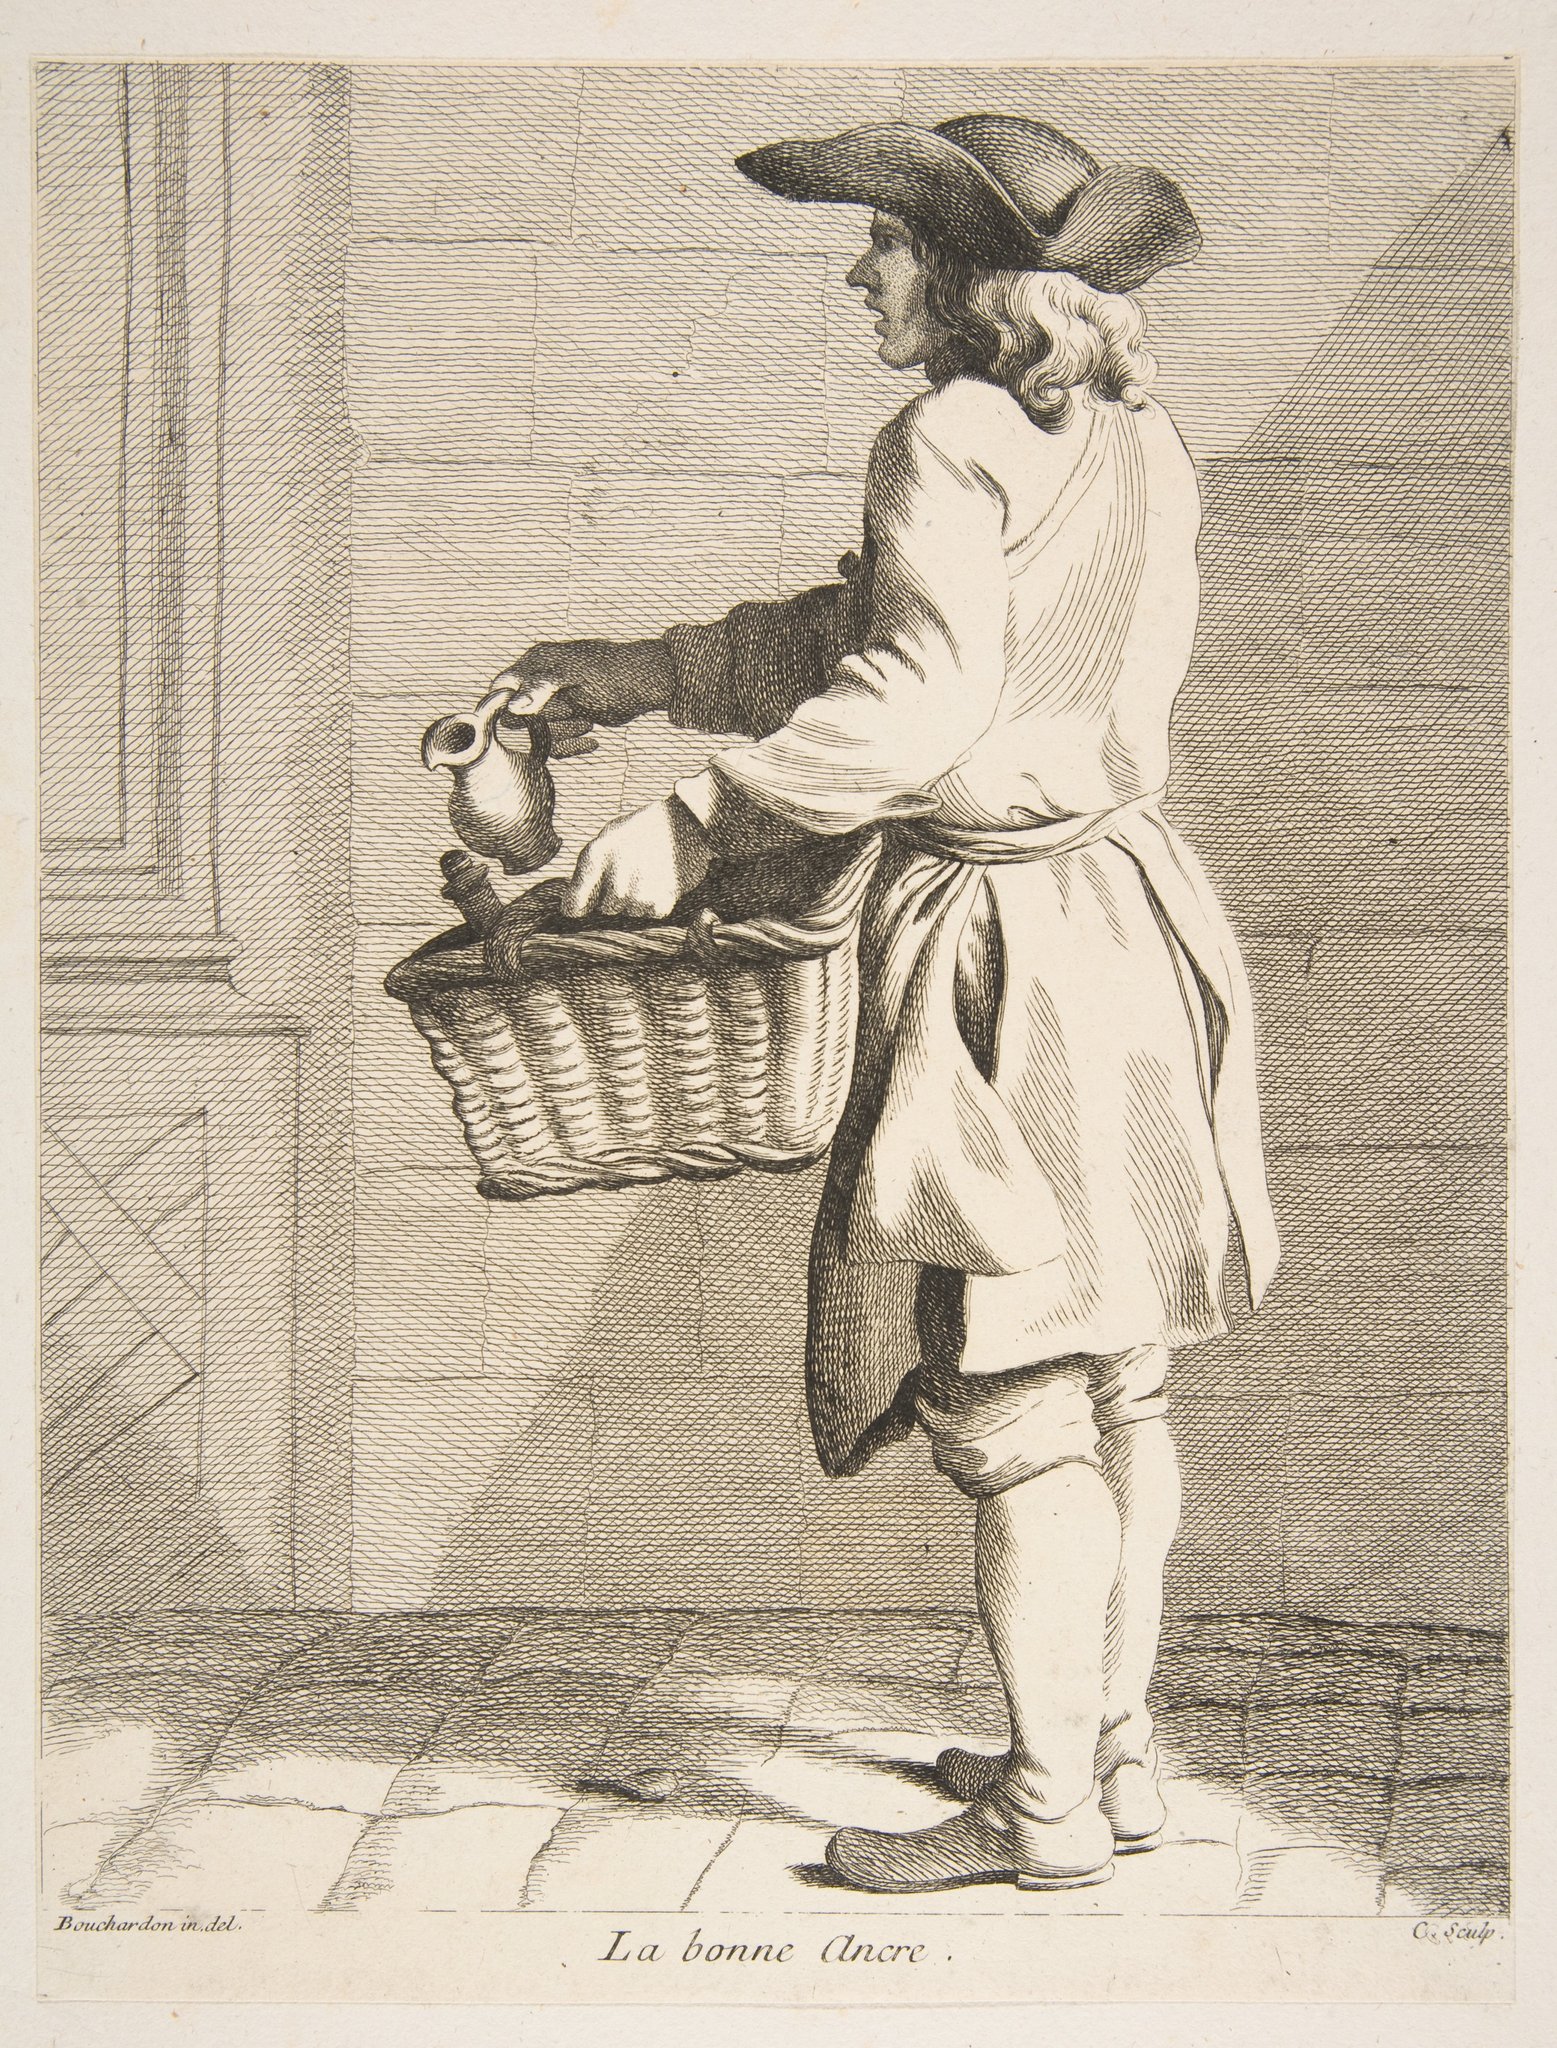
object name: print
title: Ink Seller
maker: anne claude philippe de tubières, comte de caylus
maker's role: artist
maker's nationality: french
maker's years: 1692-1765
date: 1746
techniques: engraving, etching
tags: men,baskets